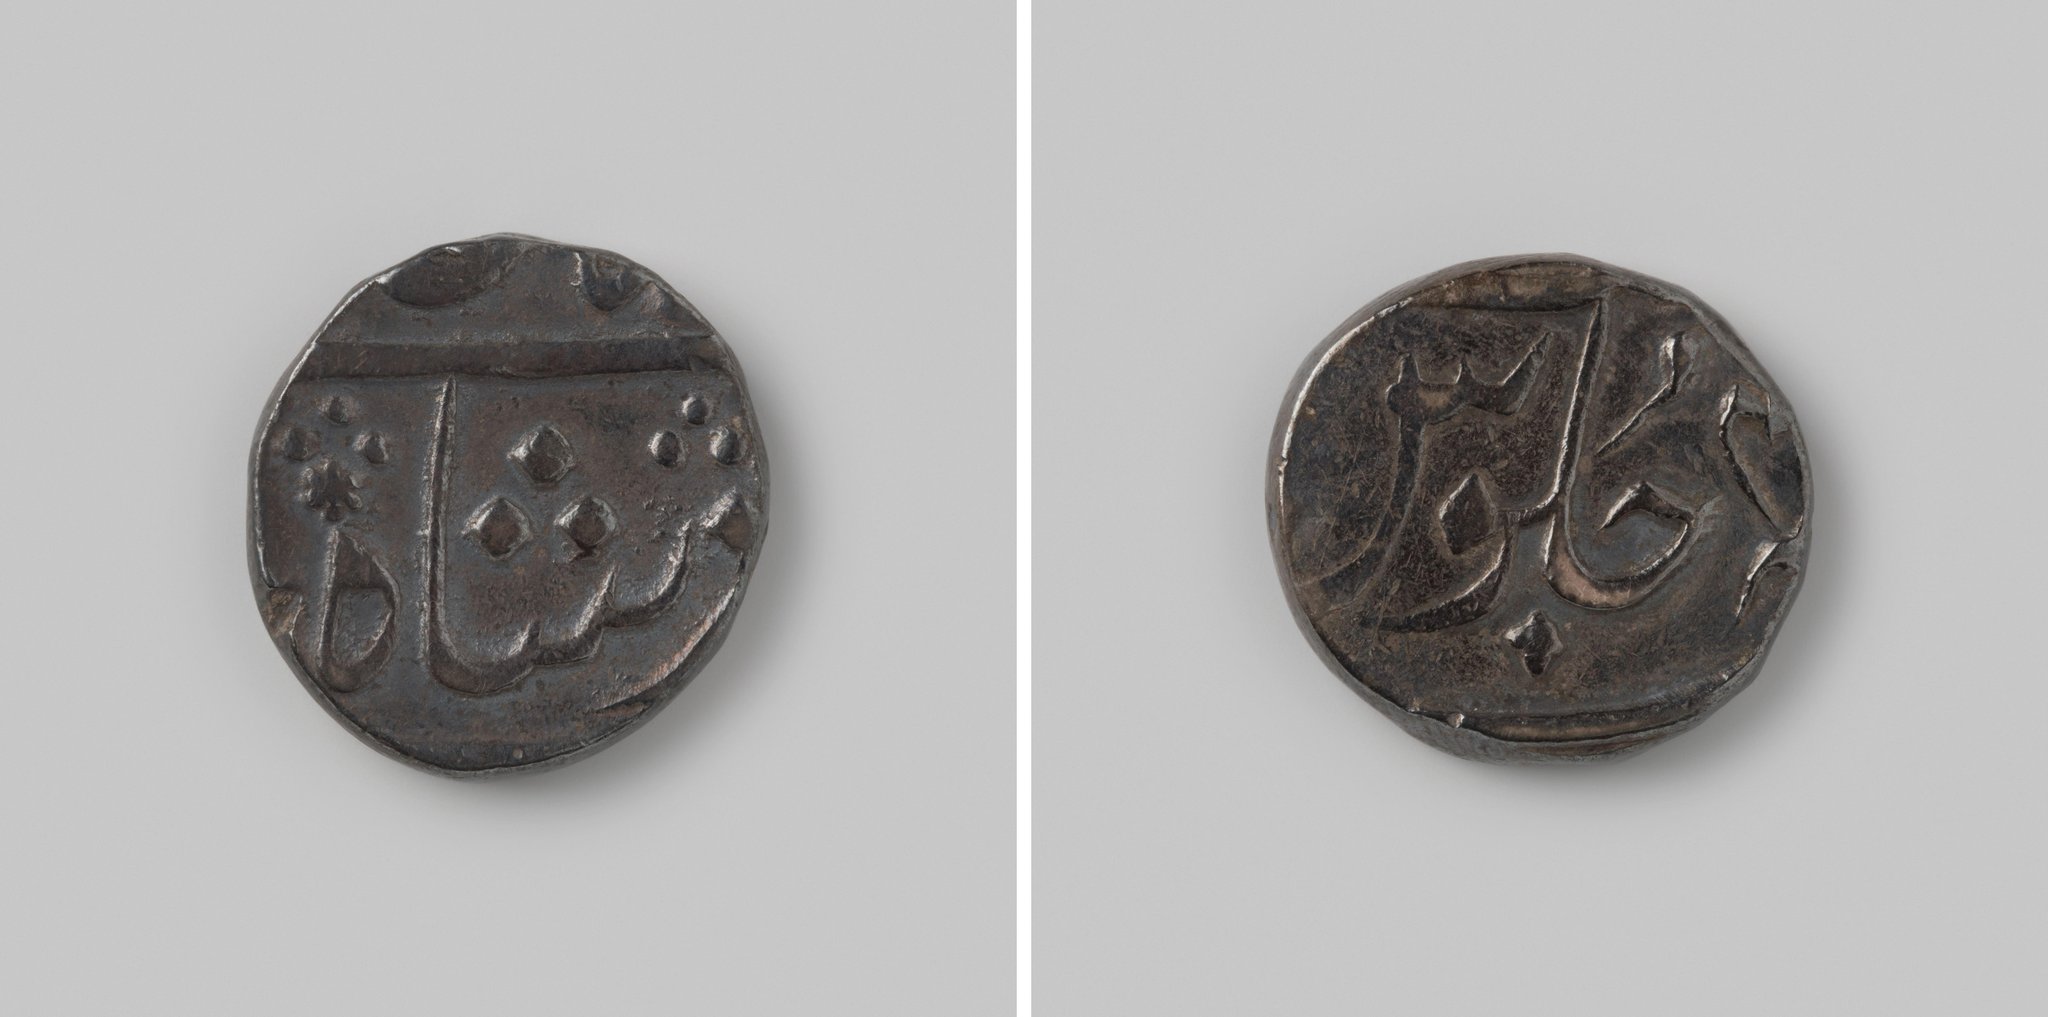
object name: coin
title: ½ Surat-roepie uit India van de Engelse Oostindische Compagnie (EIC), 1800-1820)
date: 1800-1820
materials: silver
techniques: striking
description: Zilveren munt. Voorzijde: in Arabische lettertekens in drie regels opschrift met op tweede regel naam: sjah Alem Keerzijde: in Arabische lettertekens in drie regels opschrift. Gladde rand.